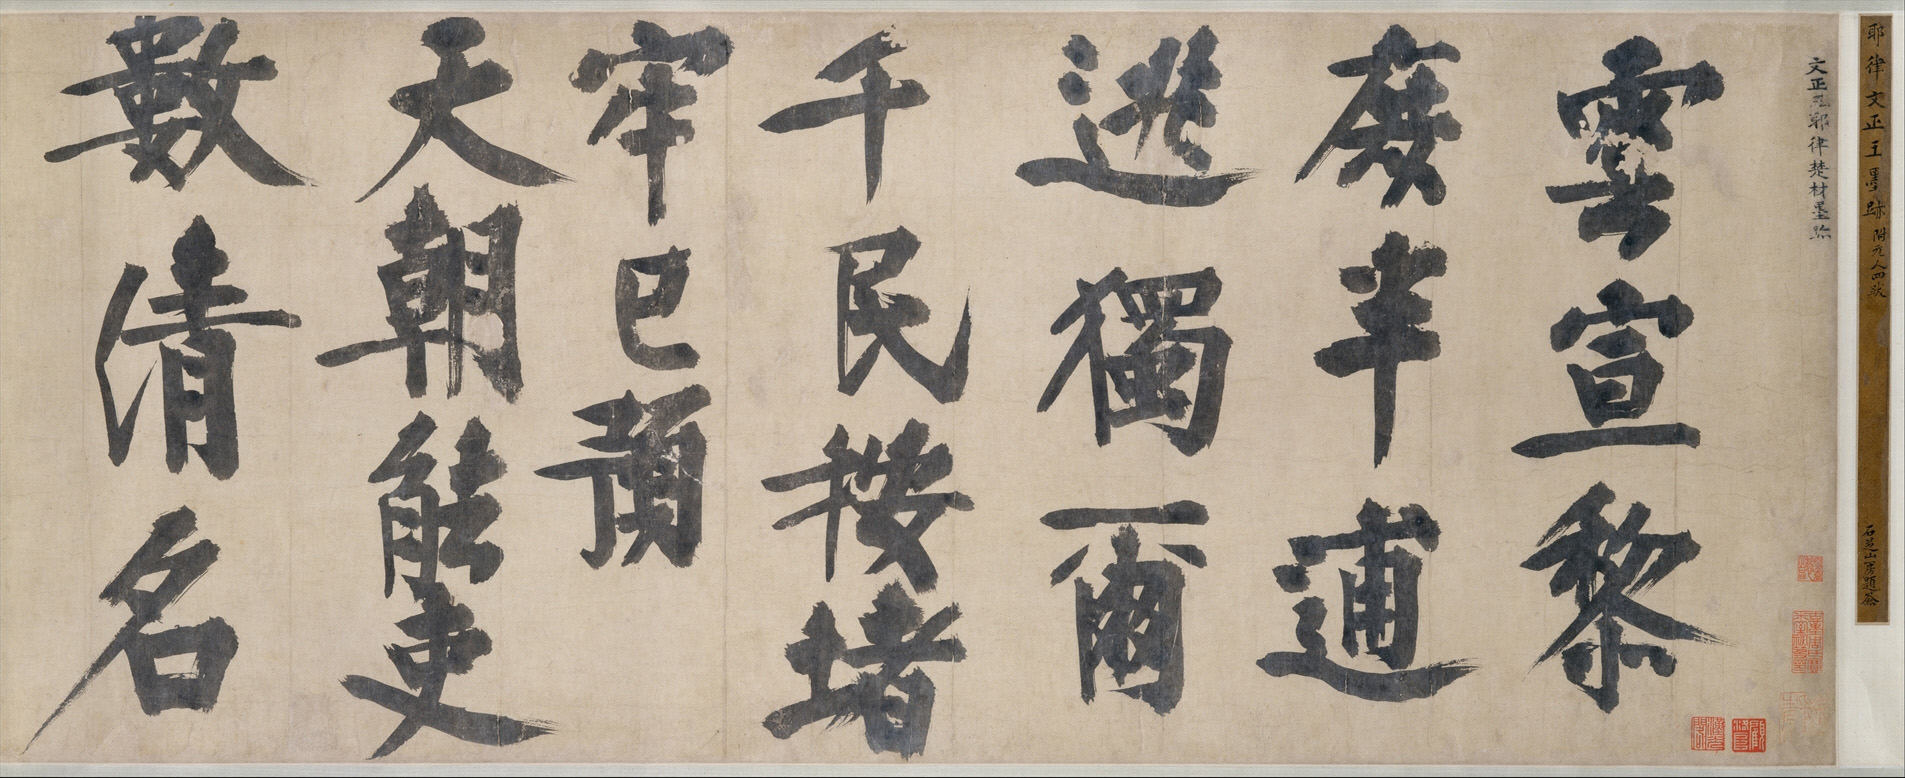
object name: handscroll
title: Poem of Farewell to Liu Man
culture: chinese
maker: yelü chucai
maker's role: artist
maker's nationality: khitan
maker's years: 1190-1244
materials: ink, paper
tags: poetry,calligraphy